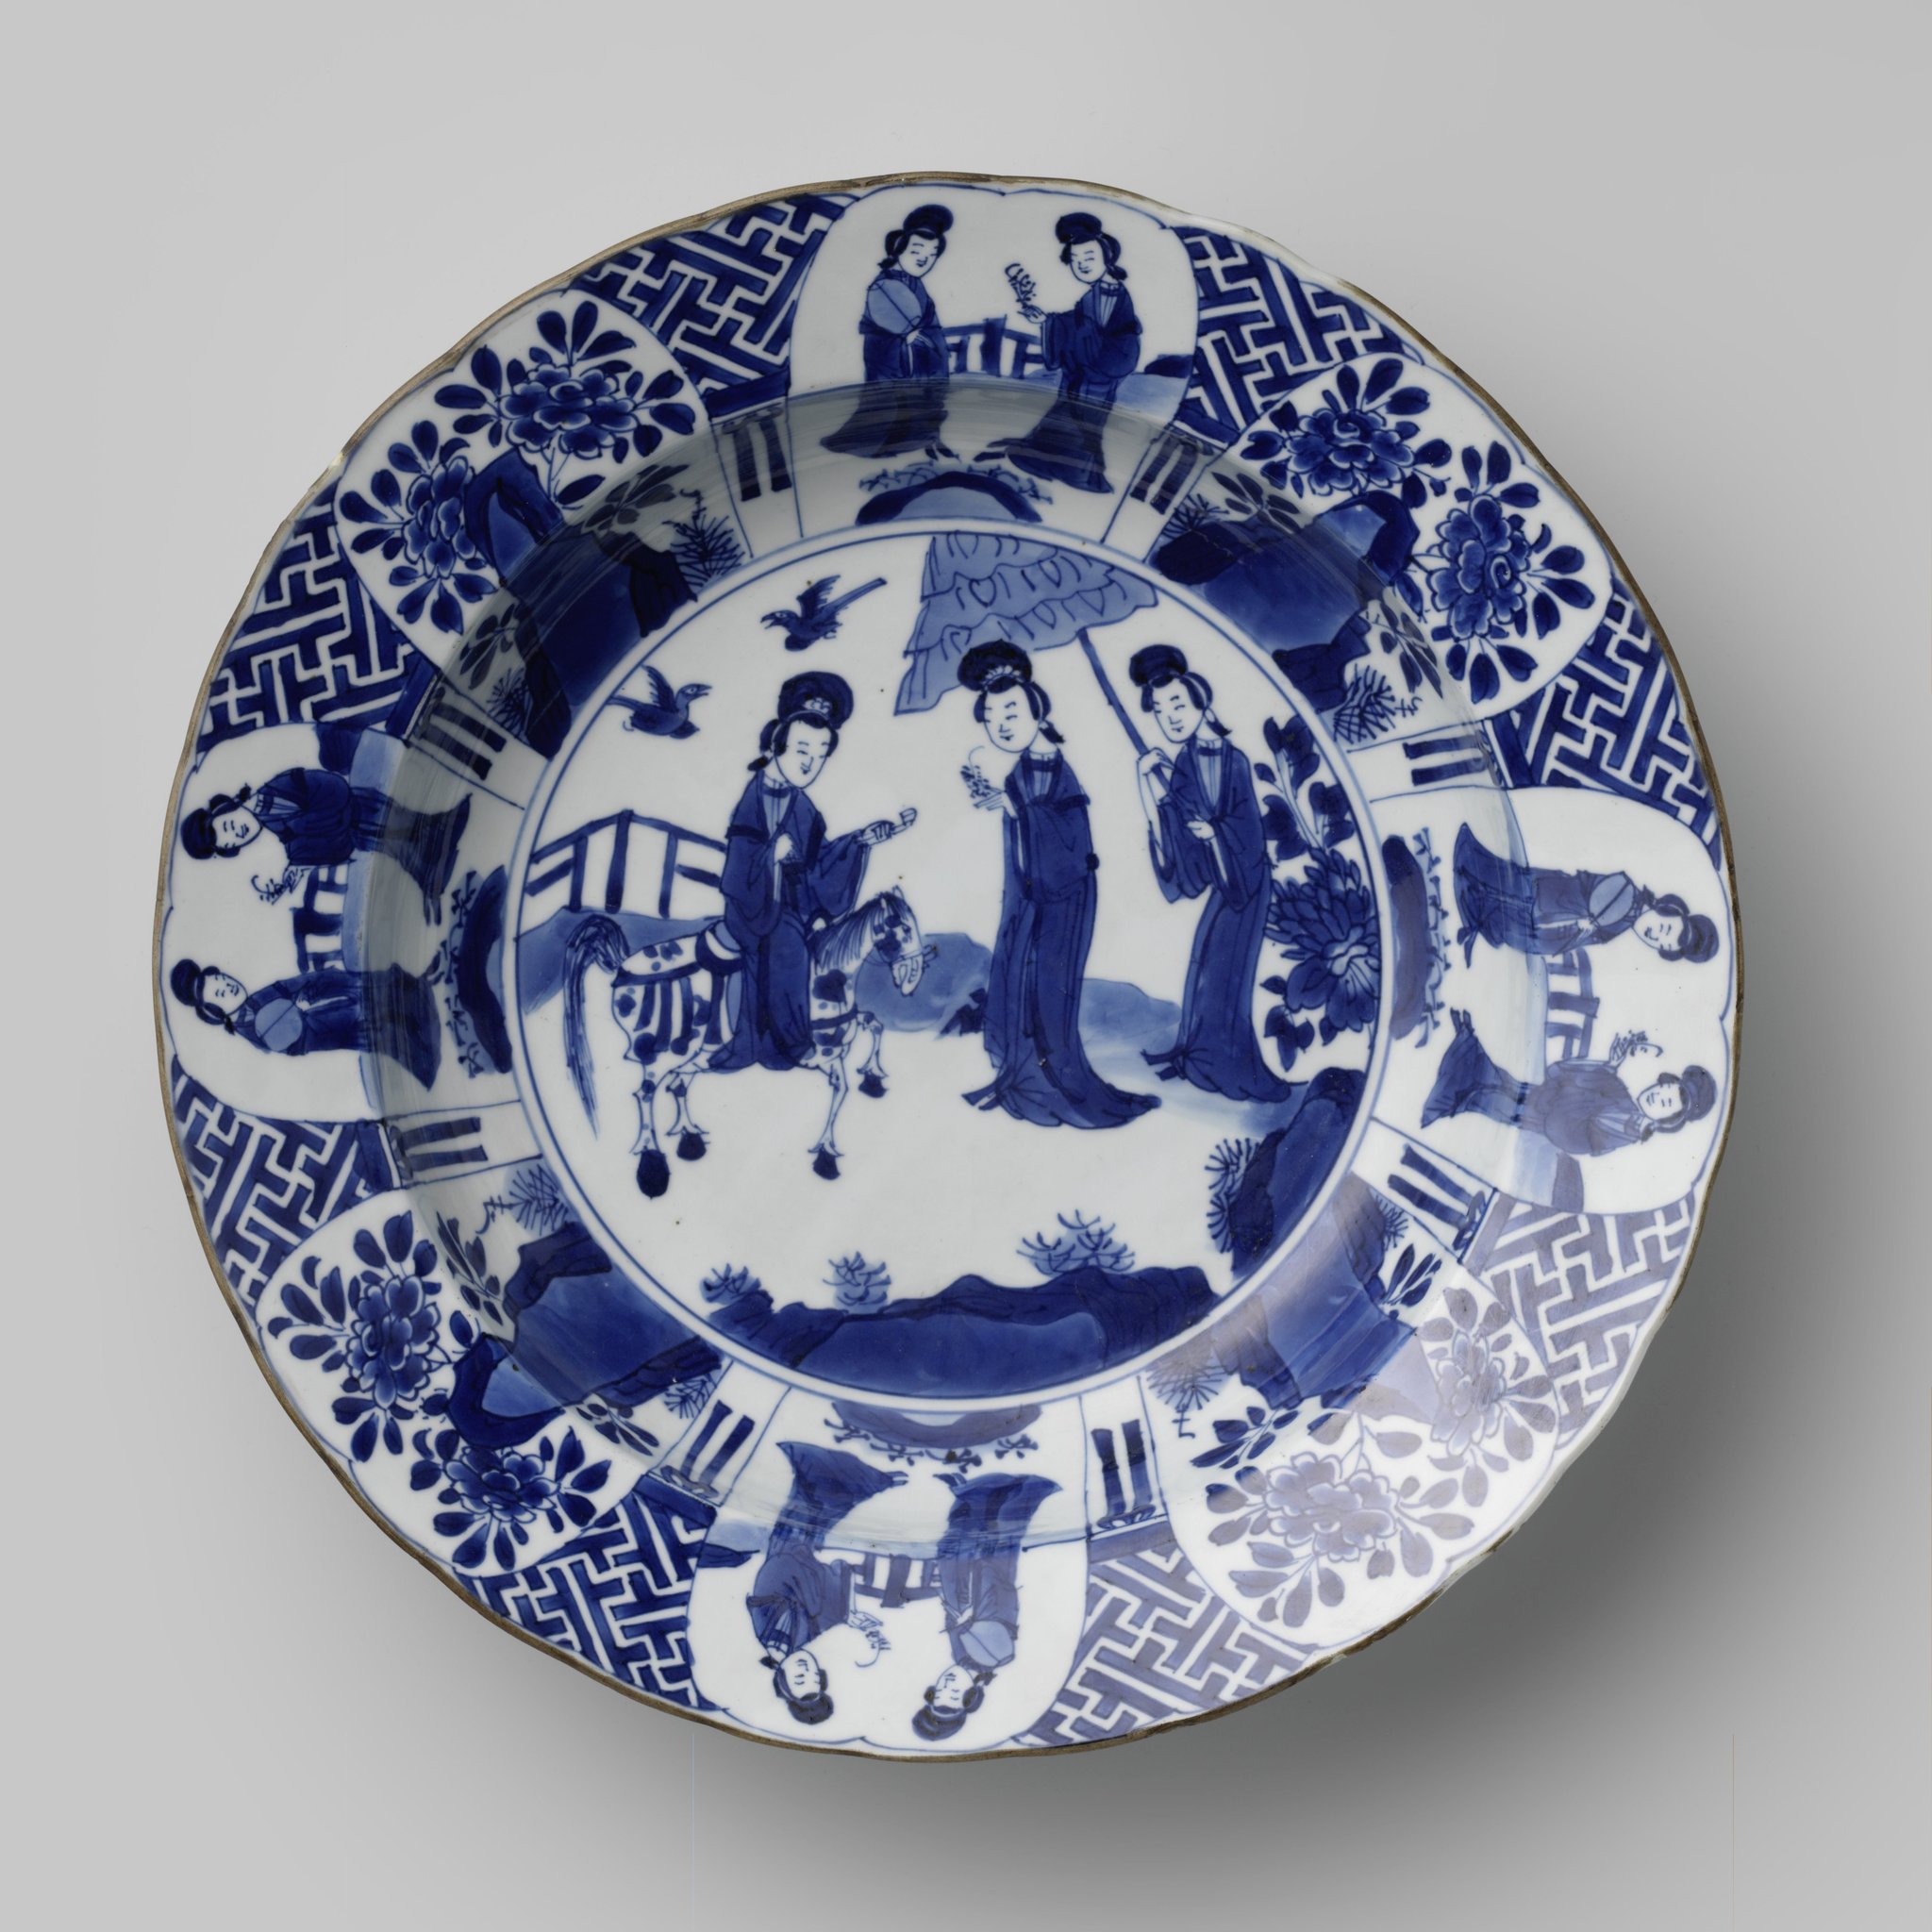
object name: platter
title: Dish with women in a fenced garden and flowering plants near a rock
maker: Anonymous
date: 1680-1720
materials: cobalt, glaze, paint, porcelain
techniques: firing, turning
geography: china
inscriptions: mark: ‘大 清 康 熙 年 製 dà qīng Kāngxī nián zhì’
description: The motif of a woman followed by a servant with a parasol was well-known in Europe. A striking feature is the woman on horseback holding what appears to be a pipe. In China, both men and women smoked pipes and it was not unusual to depict women in this way in woodcuts.